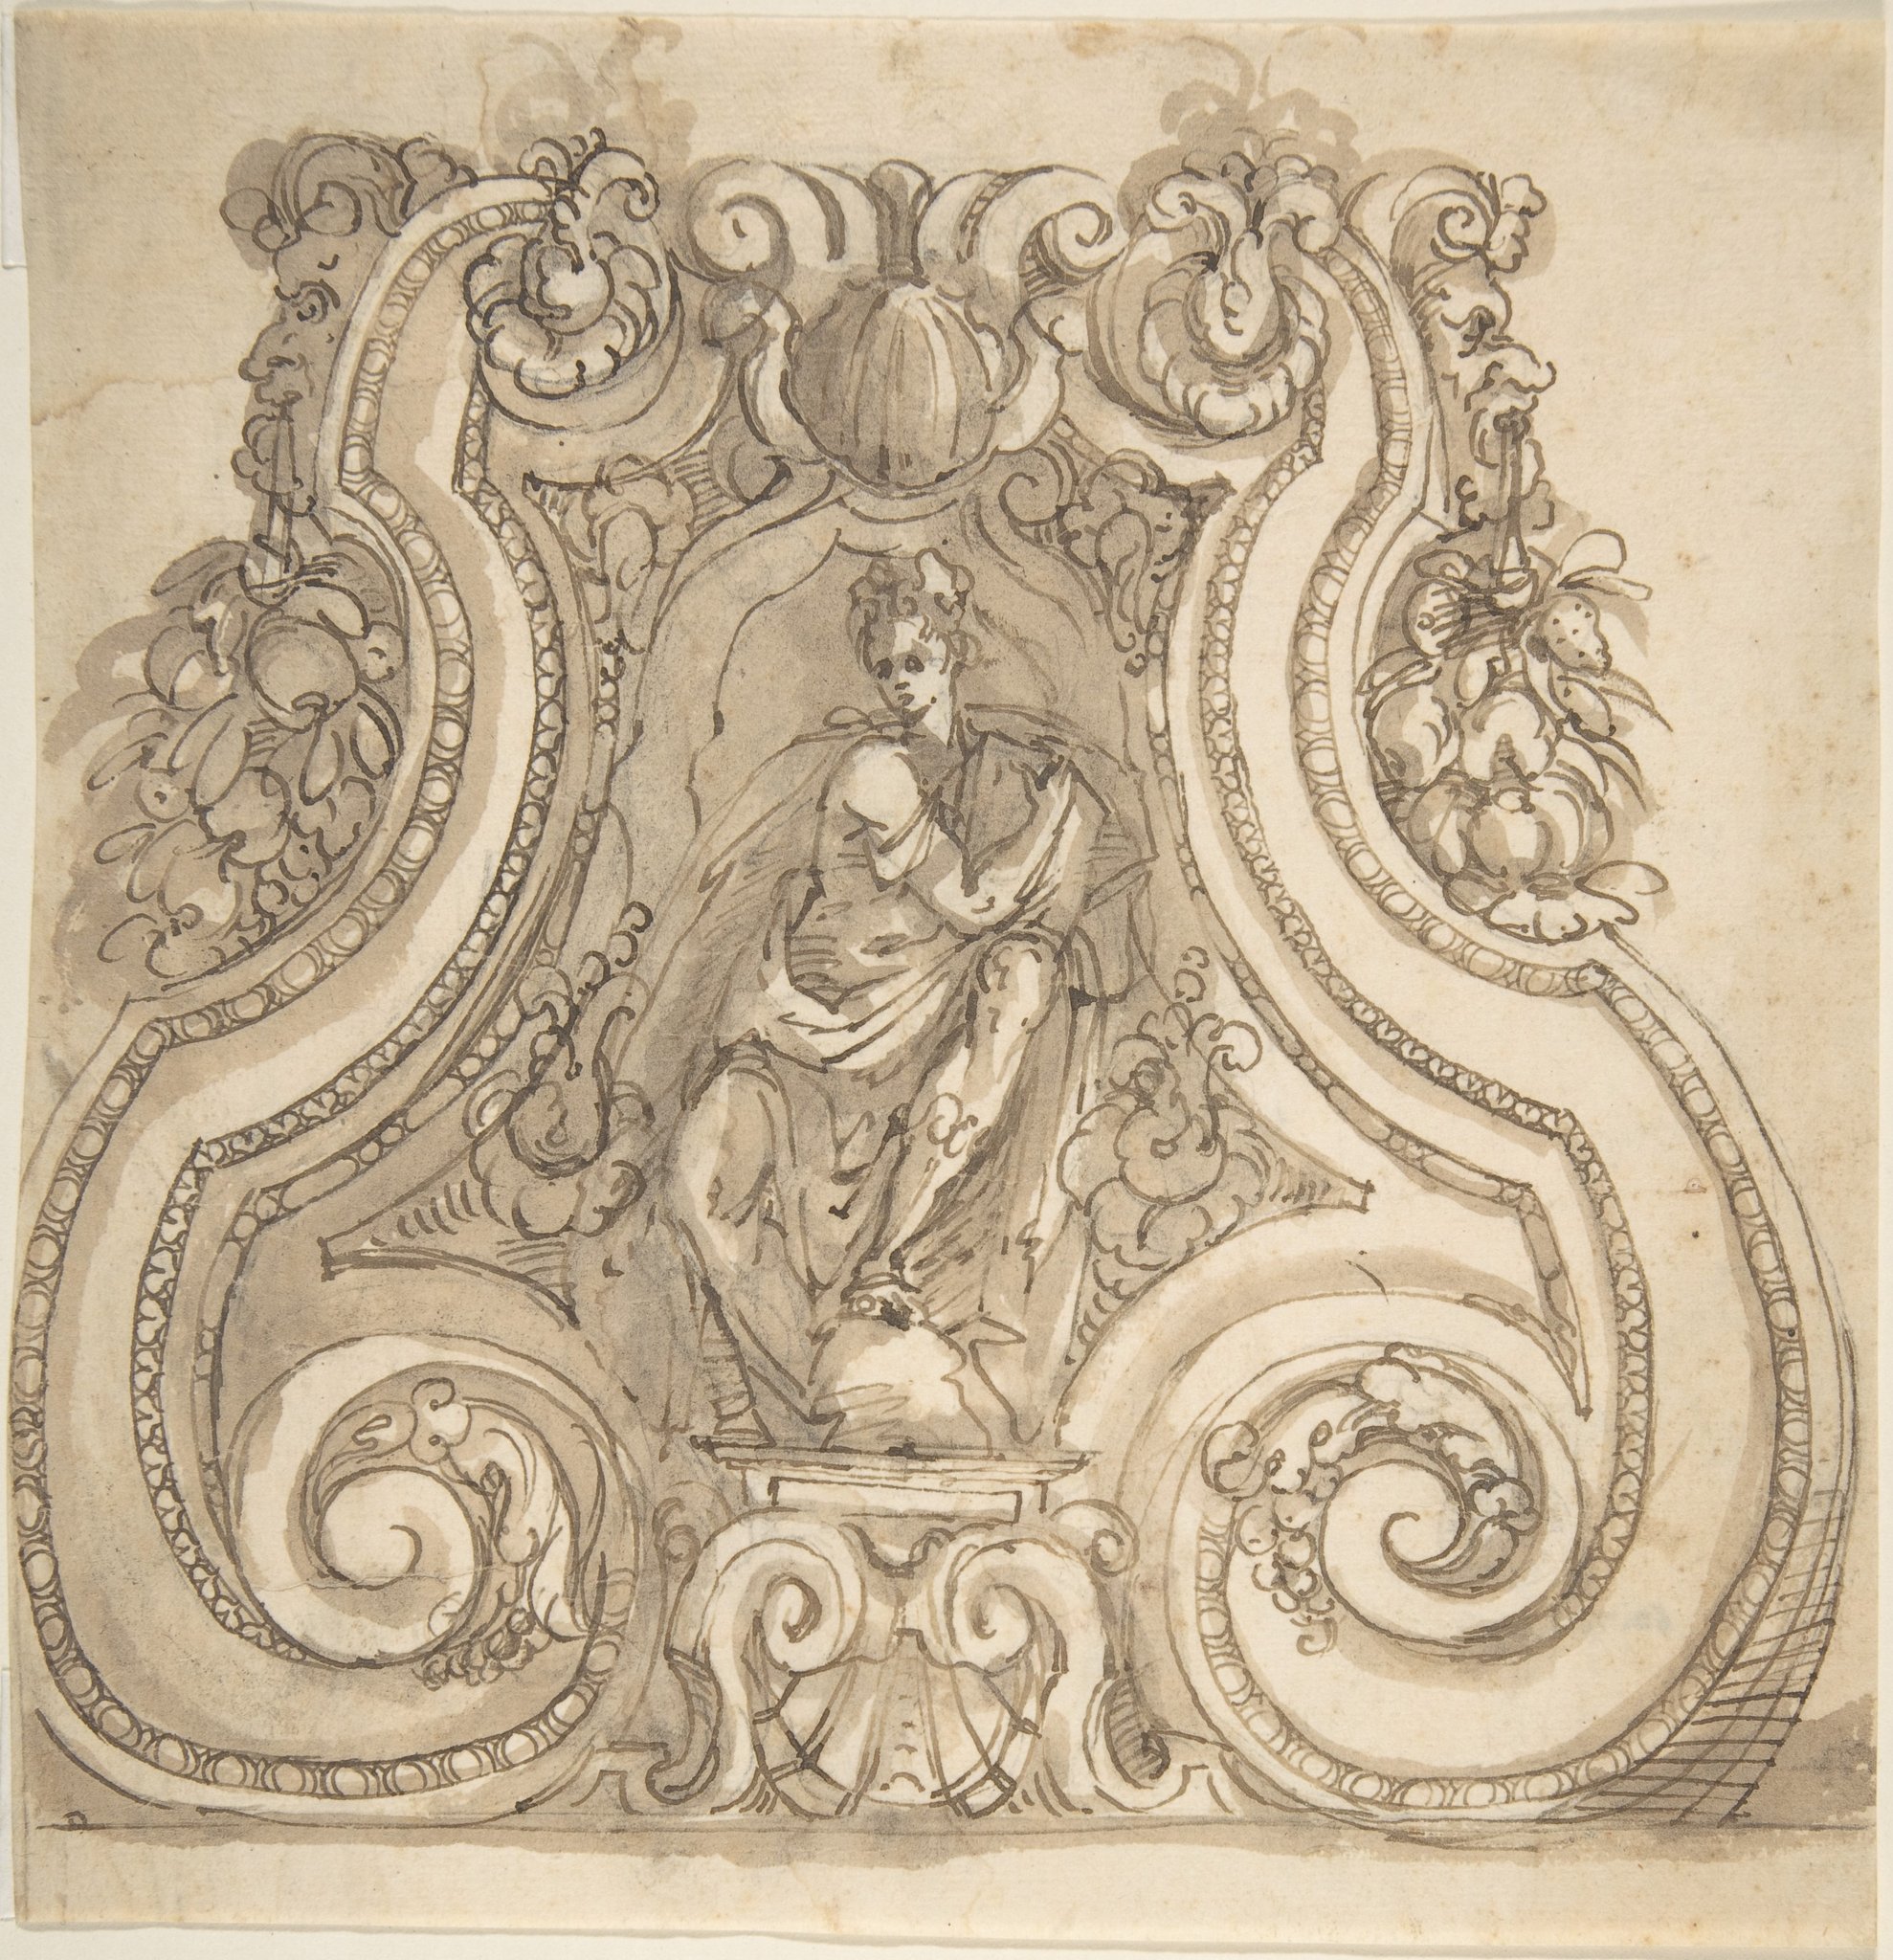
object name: drawing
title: Design for the Base of a Candle Stick with a Seated Female(?) Figure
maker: anonymous, central-italian, 16th century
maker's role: artist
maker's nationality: italian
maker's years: 1500-1600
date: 1500-1550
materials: ink, drawing material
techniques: brush, pen, wash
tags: women